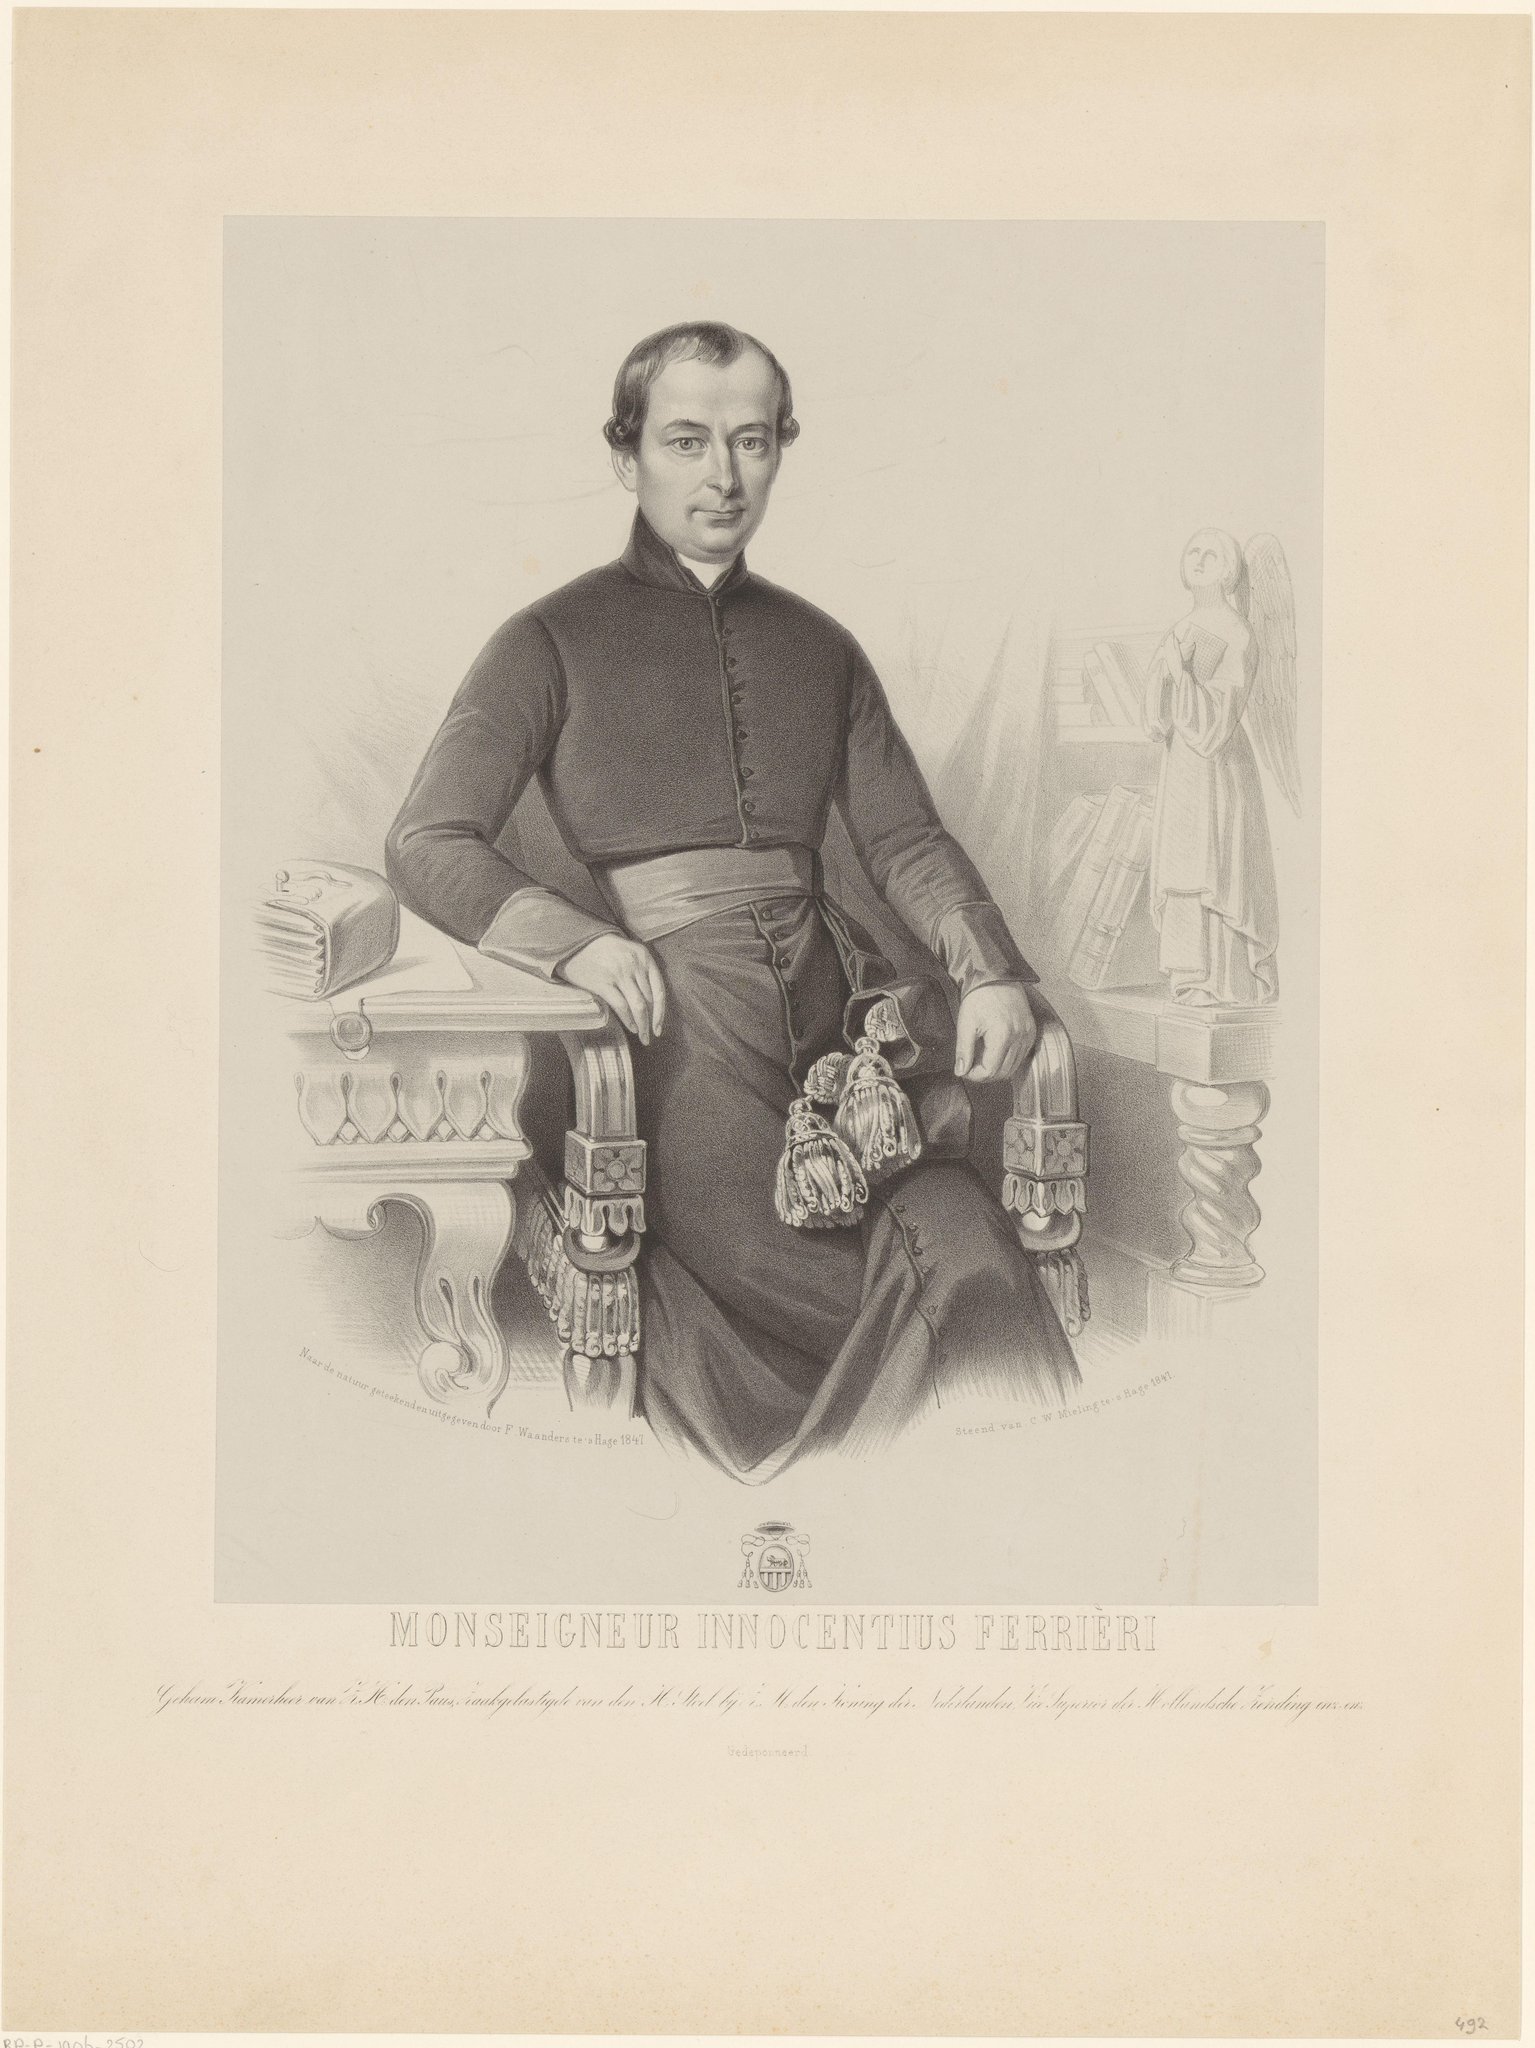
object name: print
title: Monseigneur Innocentius Ferrièri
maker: franciscus bernardus waanders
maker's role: print maker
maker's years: 1809-1880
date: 1847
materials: paper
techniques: lithograph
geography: the hague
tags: rome, historical persons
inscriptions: : ‘Gedeponeerd.’, collector's mark: Lugt 2228